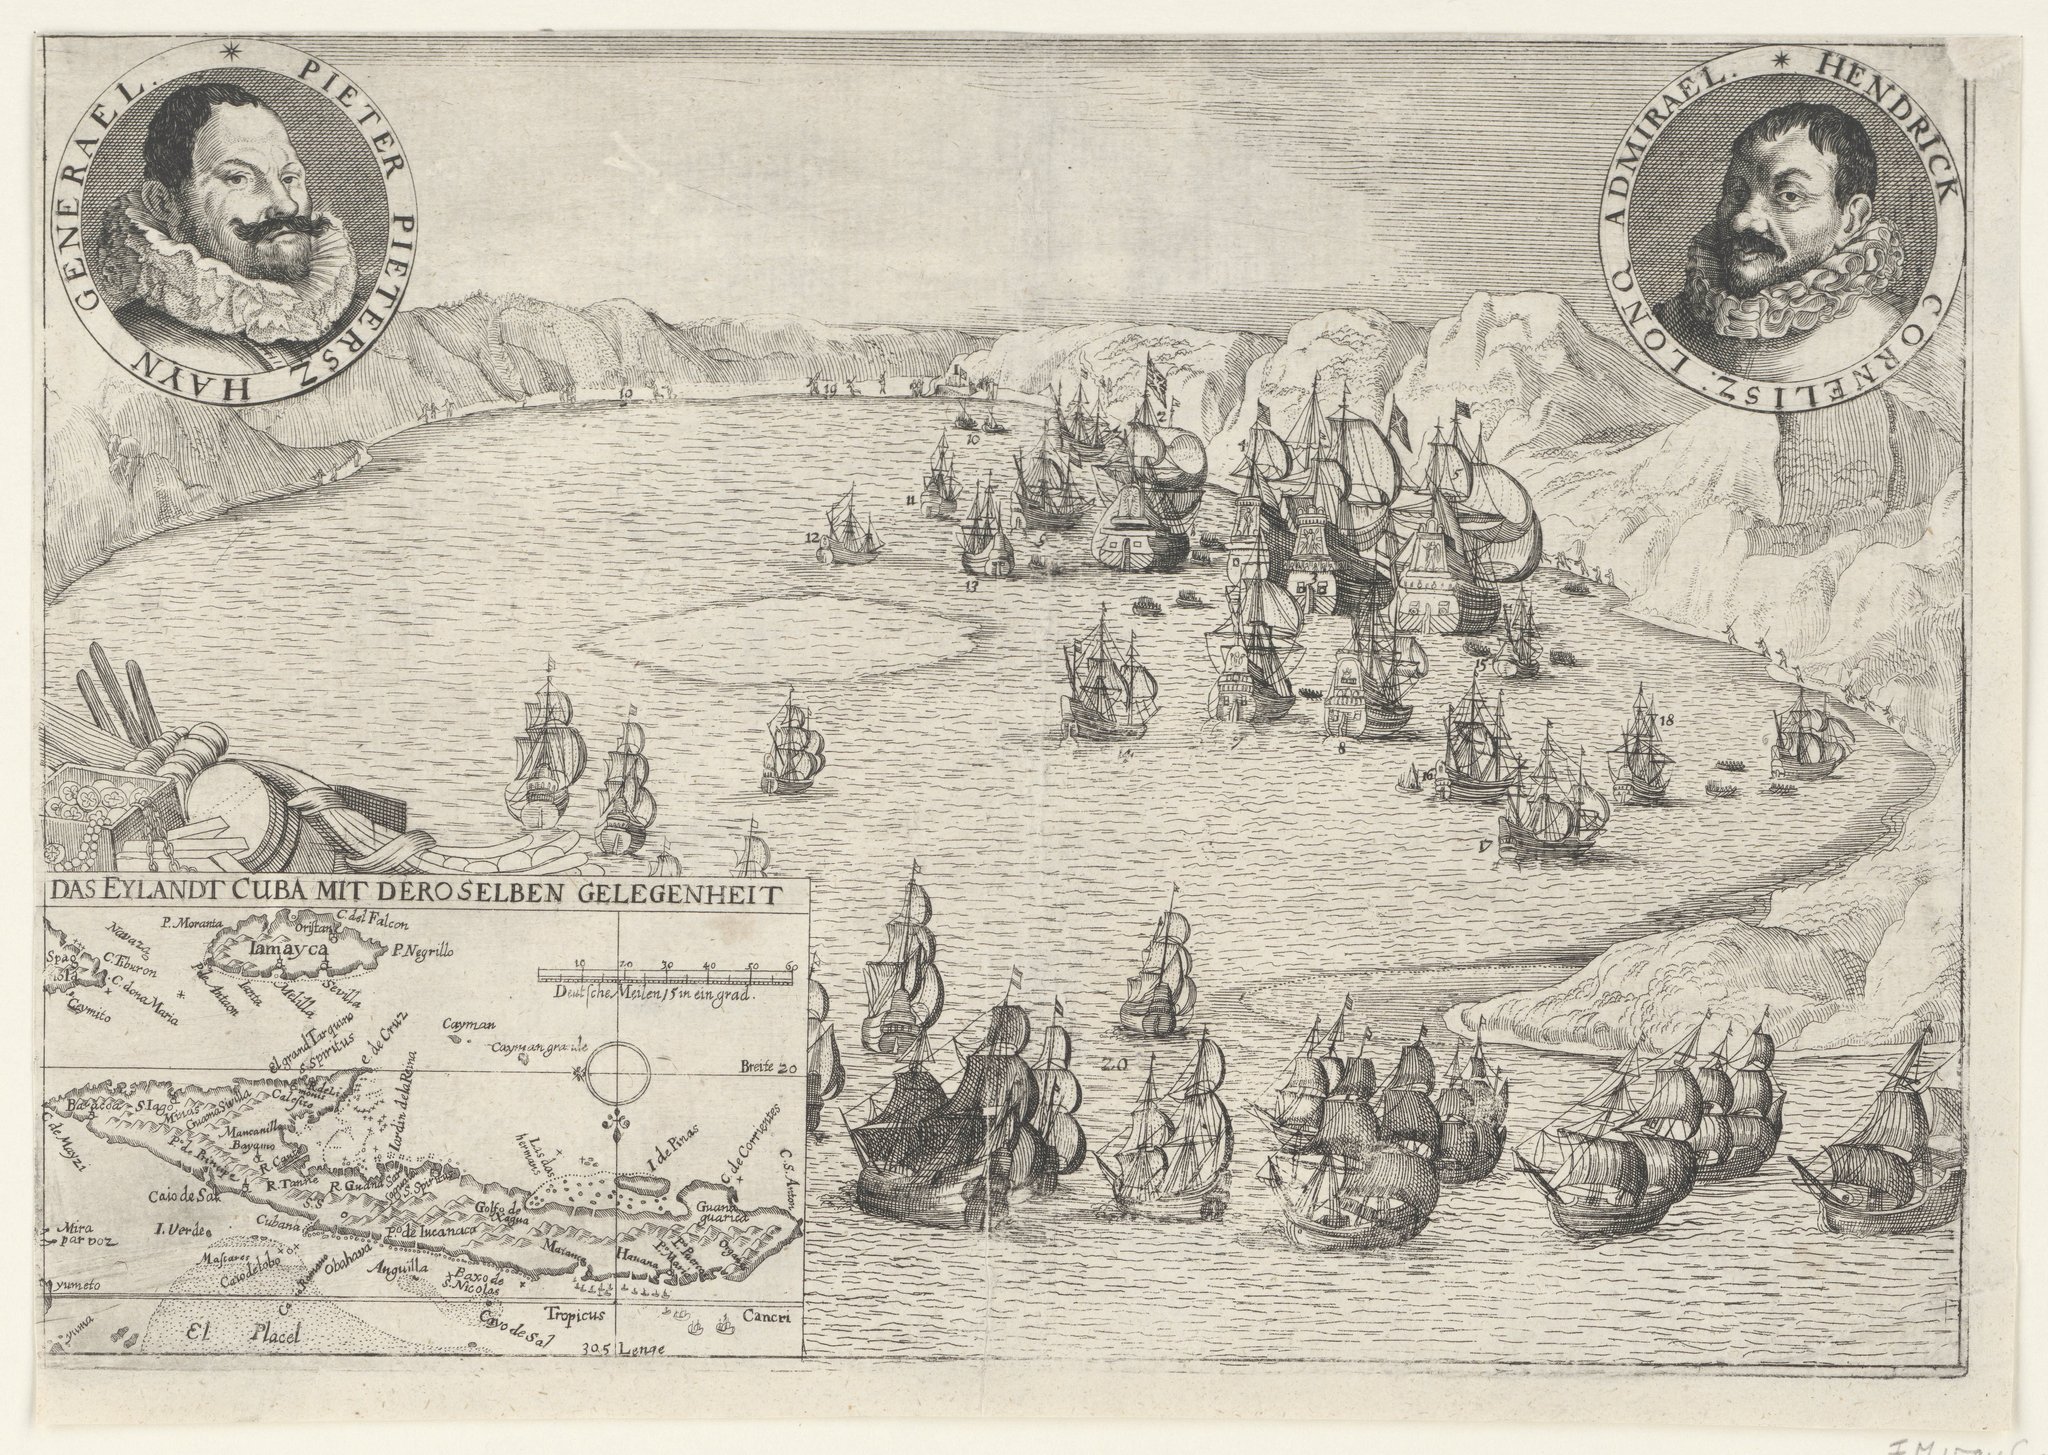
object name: print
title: Verovering van de Zilvervloot in de Baai van Matanzas door admiraal Piet Hein, 1628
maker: claes jansz. visscher (ii)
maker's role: draughtsman, print maker, publisher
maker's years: 1586-1652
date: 1628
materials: paper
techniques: etching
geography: amsterdam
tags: delfshaven, ships (in general) (+ propulsion of vehicle, ship, etc. by wind), capture of the spanish treasure fleet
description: Verovering van de Zilvervloot in de Baai van Matanzas door een vloot van de WIC onder bevel van admiraal Piet Hein, 8 september 1628. Linksonder een kaart van het eiland Cuba. Bovenaan ronde portretten van de admiralen Hendrick Cornelisz. Loncq en Piet Hein. Bij de prent behoort een tekstblad.